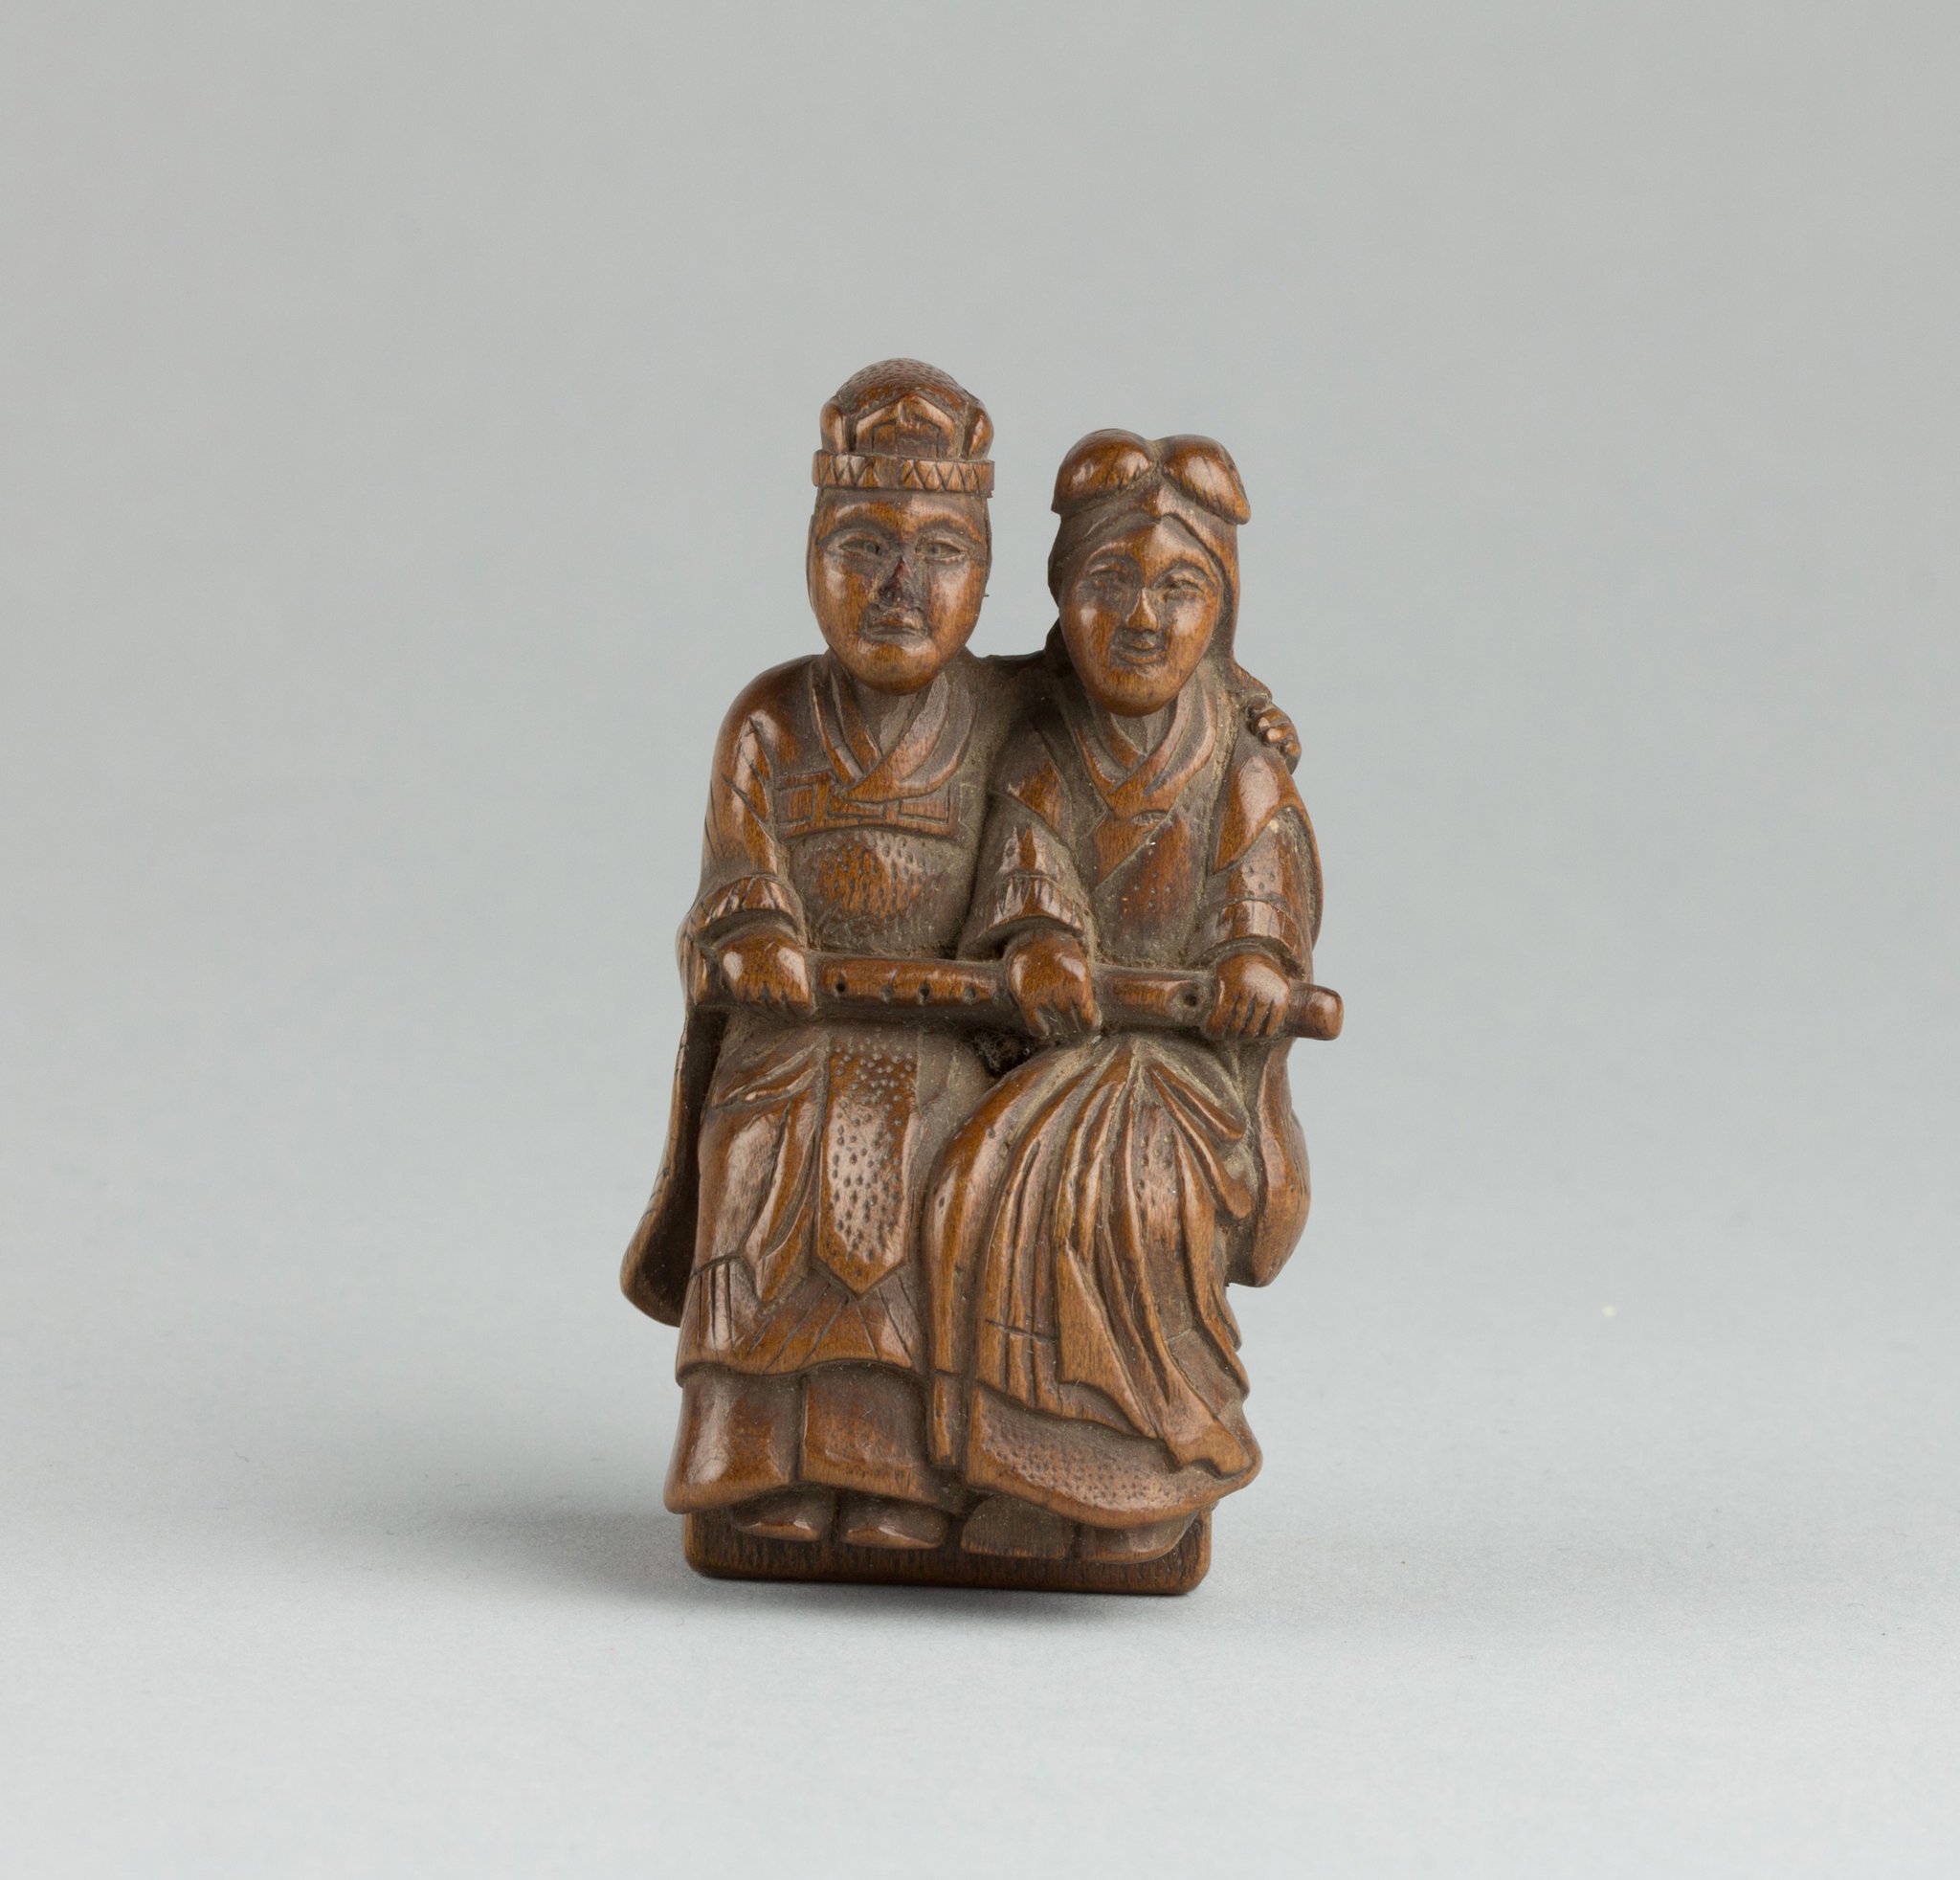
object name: netsuke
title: Netsuke of Man and Woman Sitting on a Box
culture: japanese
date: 1801-1900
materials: wood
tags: men,women